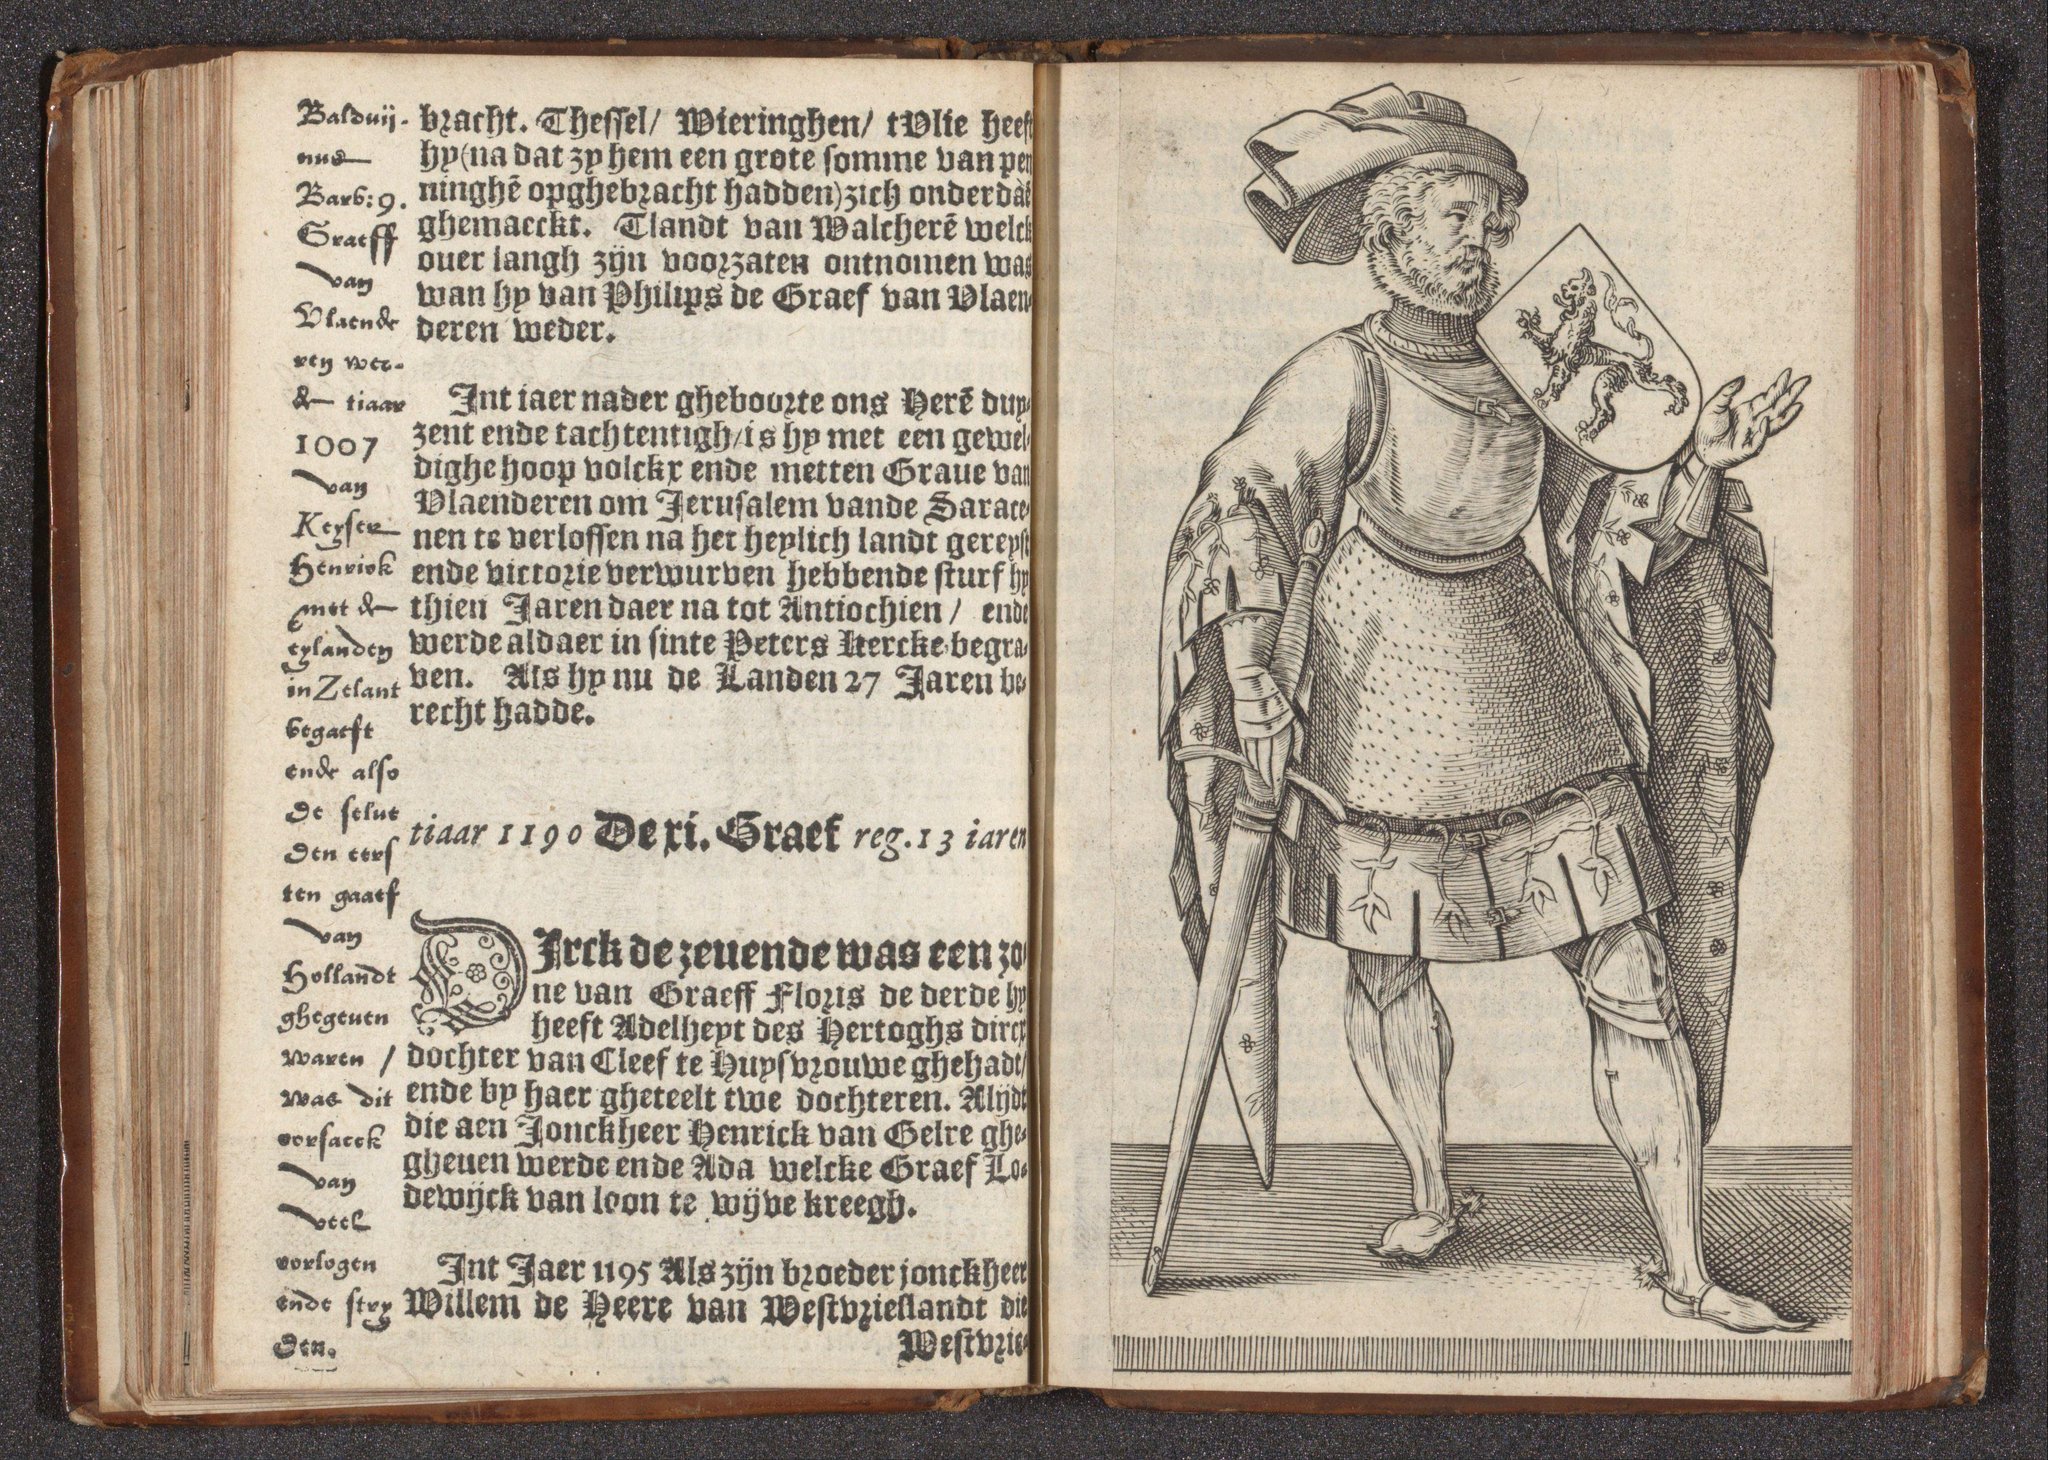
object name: print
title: Affkomst ende korte historie der graven van Hollandt Zeelandt ende Vrieslandt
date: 1586-1587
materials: paper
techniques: engraving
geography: haarlem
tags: historical persons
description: Graaf Dirk VII van Holland, ten voeten uit. Zijn zwaard steunt met de punt op de grond. Op het wapen een klimmende leeuw. De prent maakt deel uit van een boek met beschrijvingen en voorstellingen van de graven van Holland, Zeeland en Friesland.